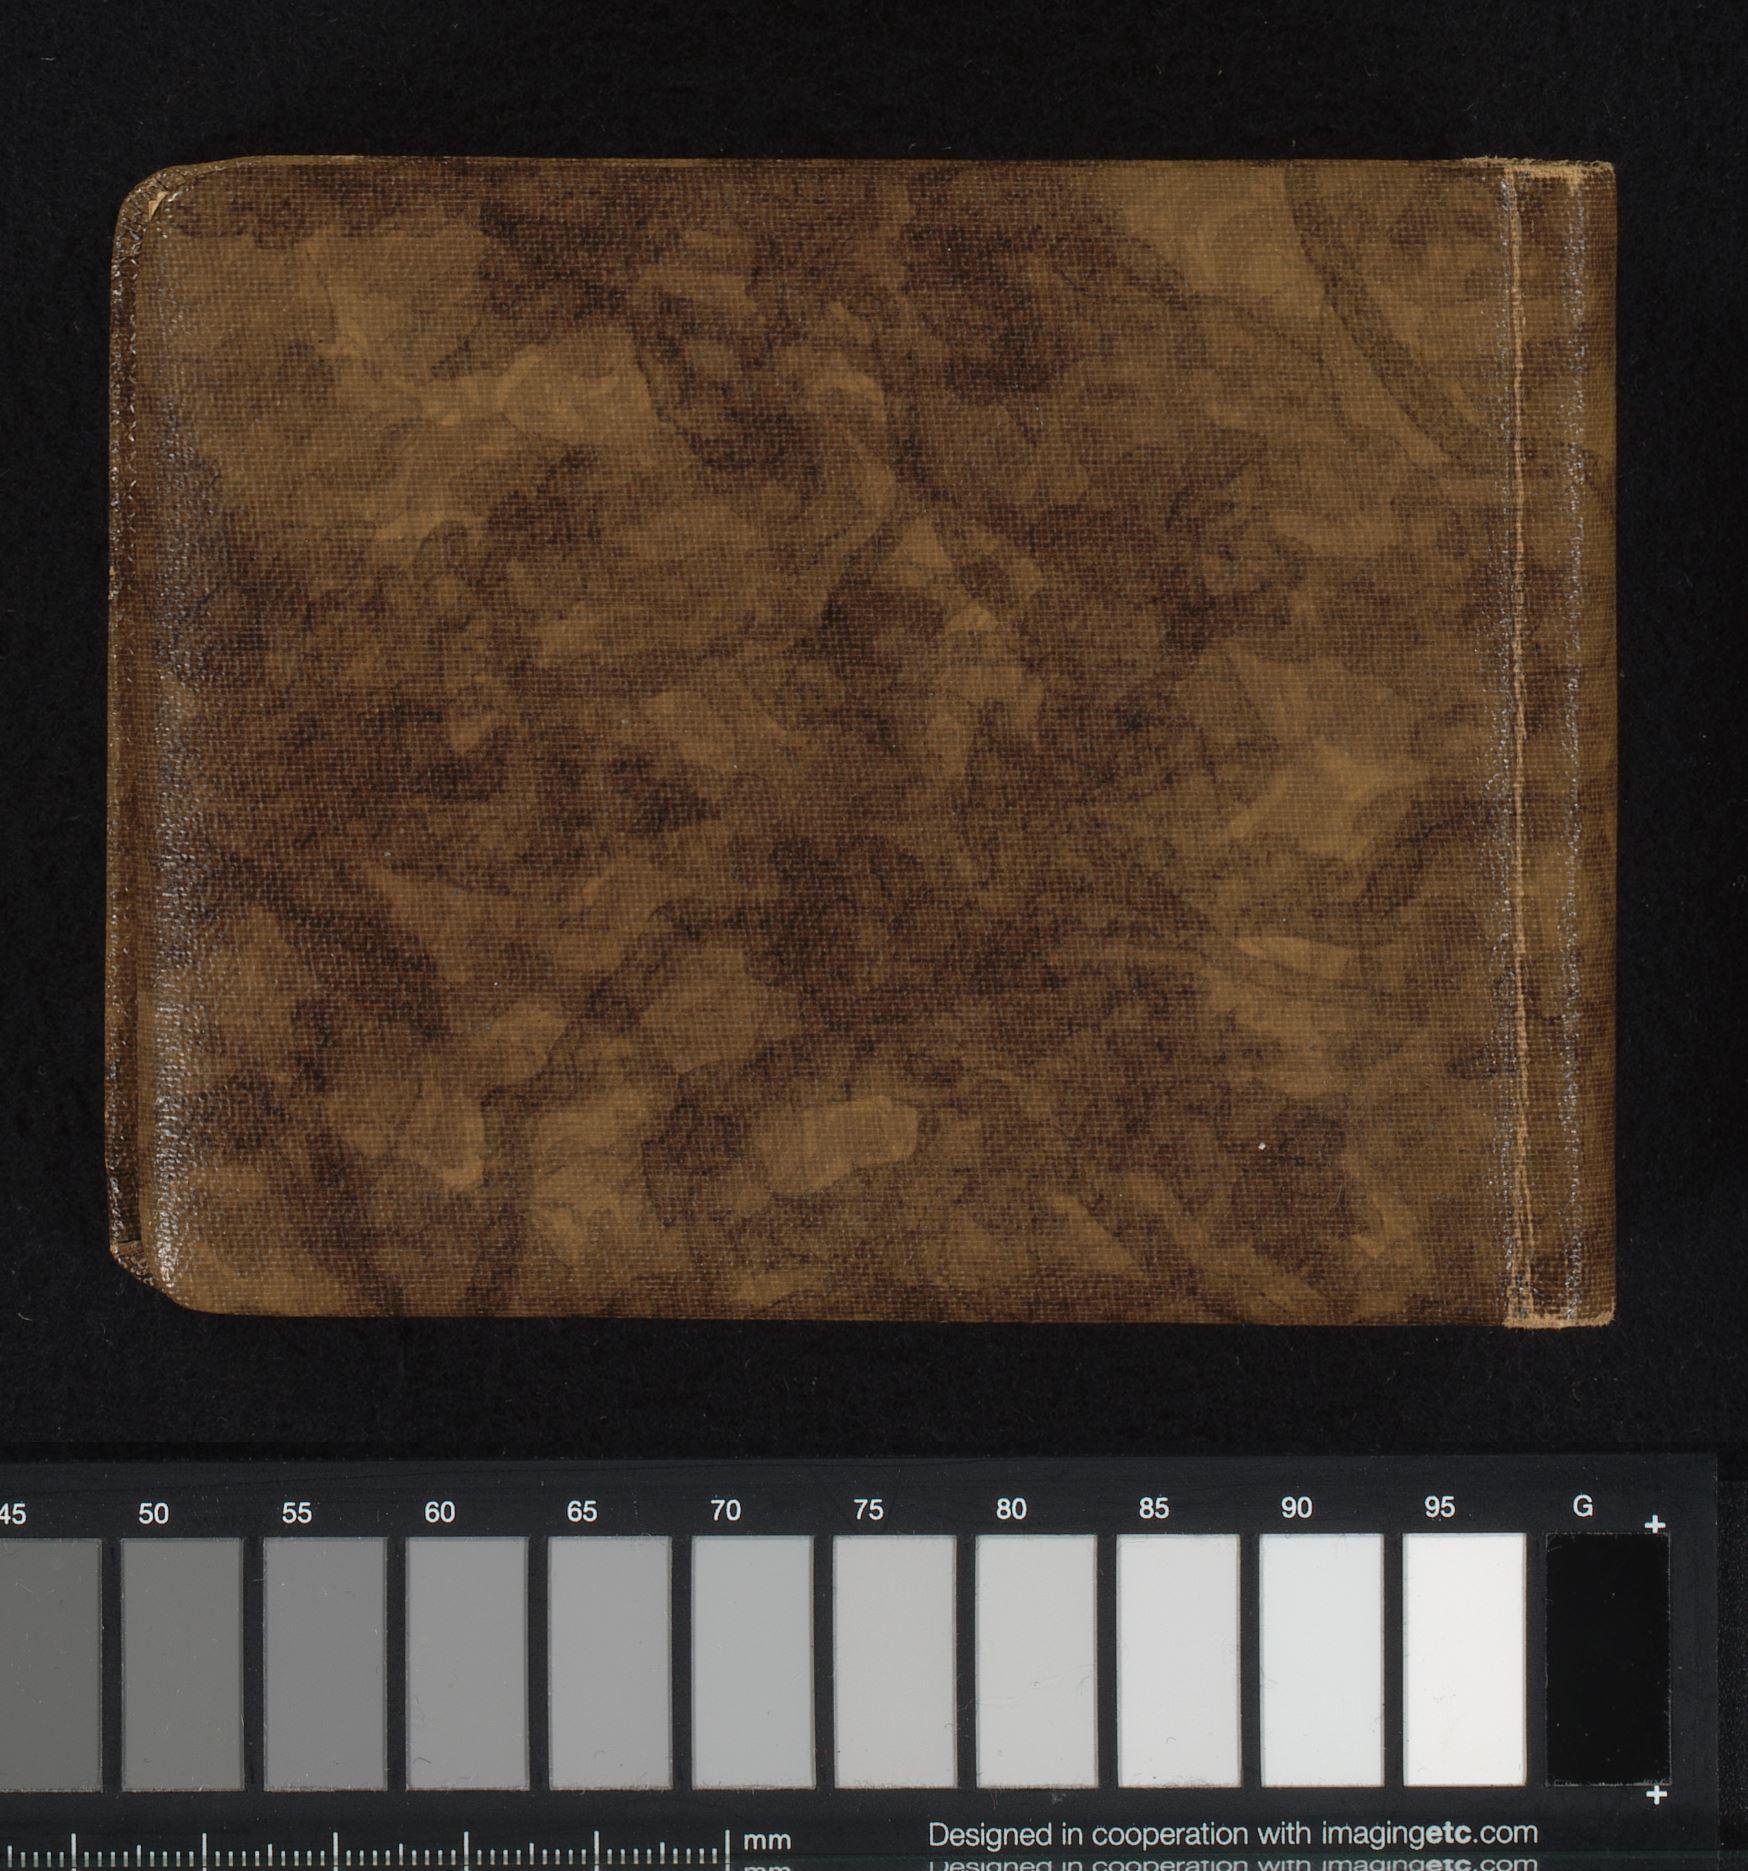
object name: photograph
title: Meisje op driewieler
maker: Anonymous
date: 1908-1939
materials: cardboard, photographic support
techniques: gelatin silver print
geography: deventer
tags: tricycle, family life at home, (playing with) toys, deventer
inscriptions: inscription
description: Albumblad met een foto van een meisje in de tuin op een driewieler, te Deventer. Onderdeel van het familiealbum 1938-1939.